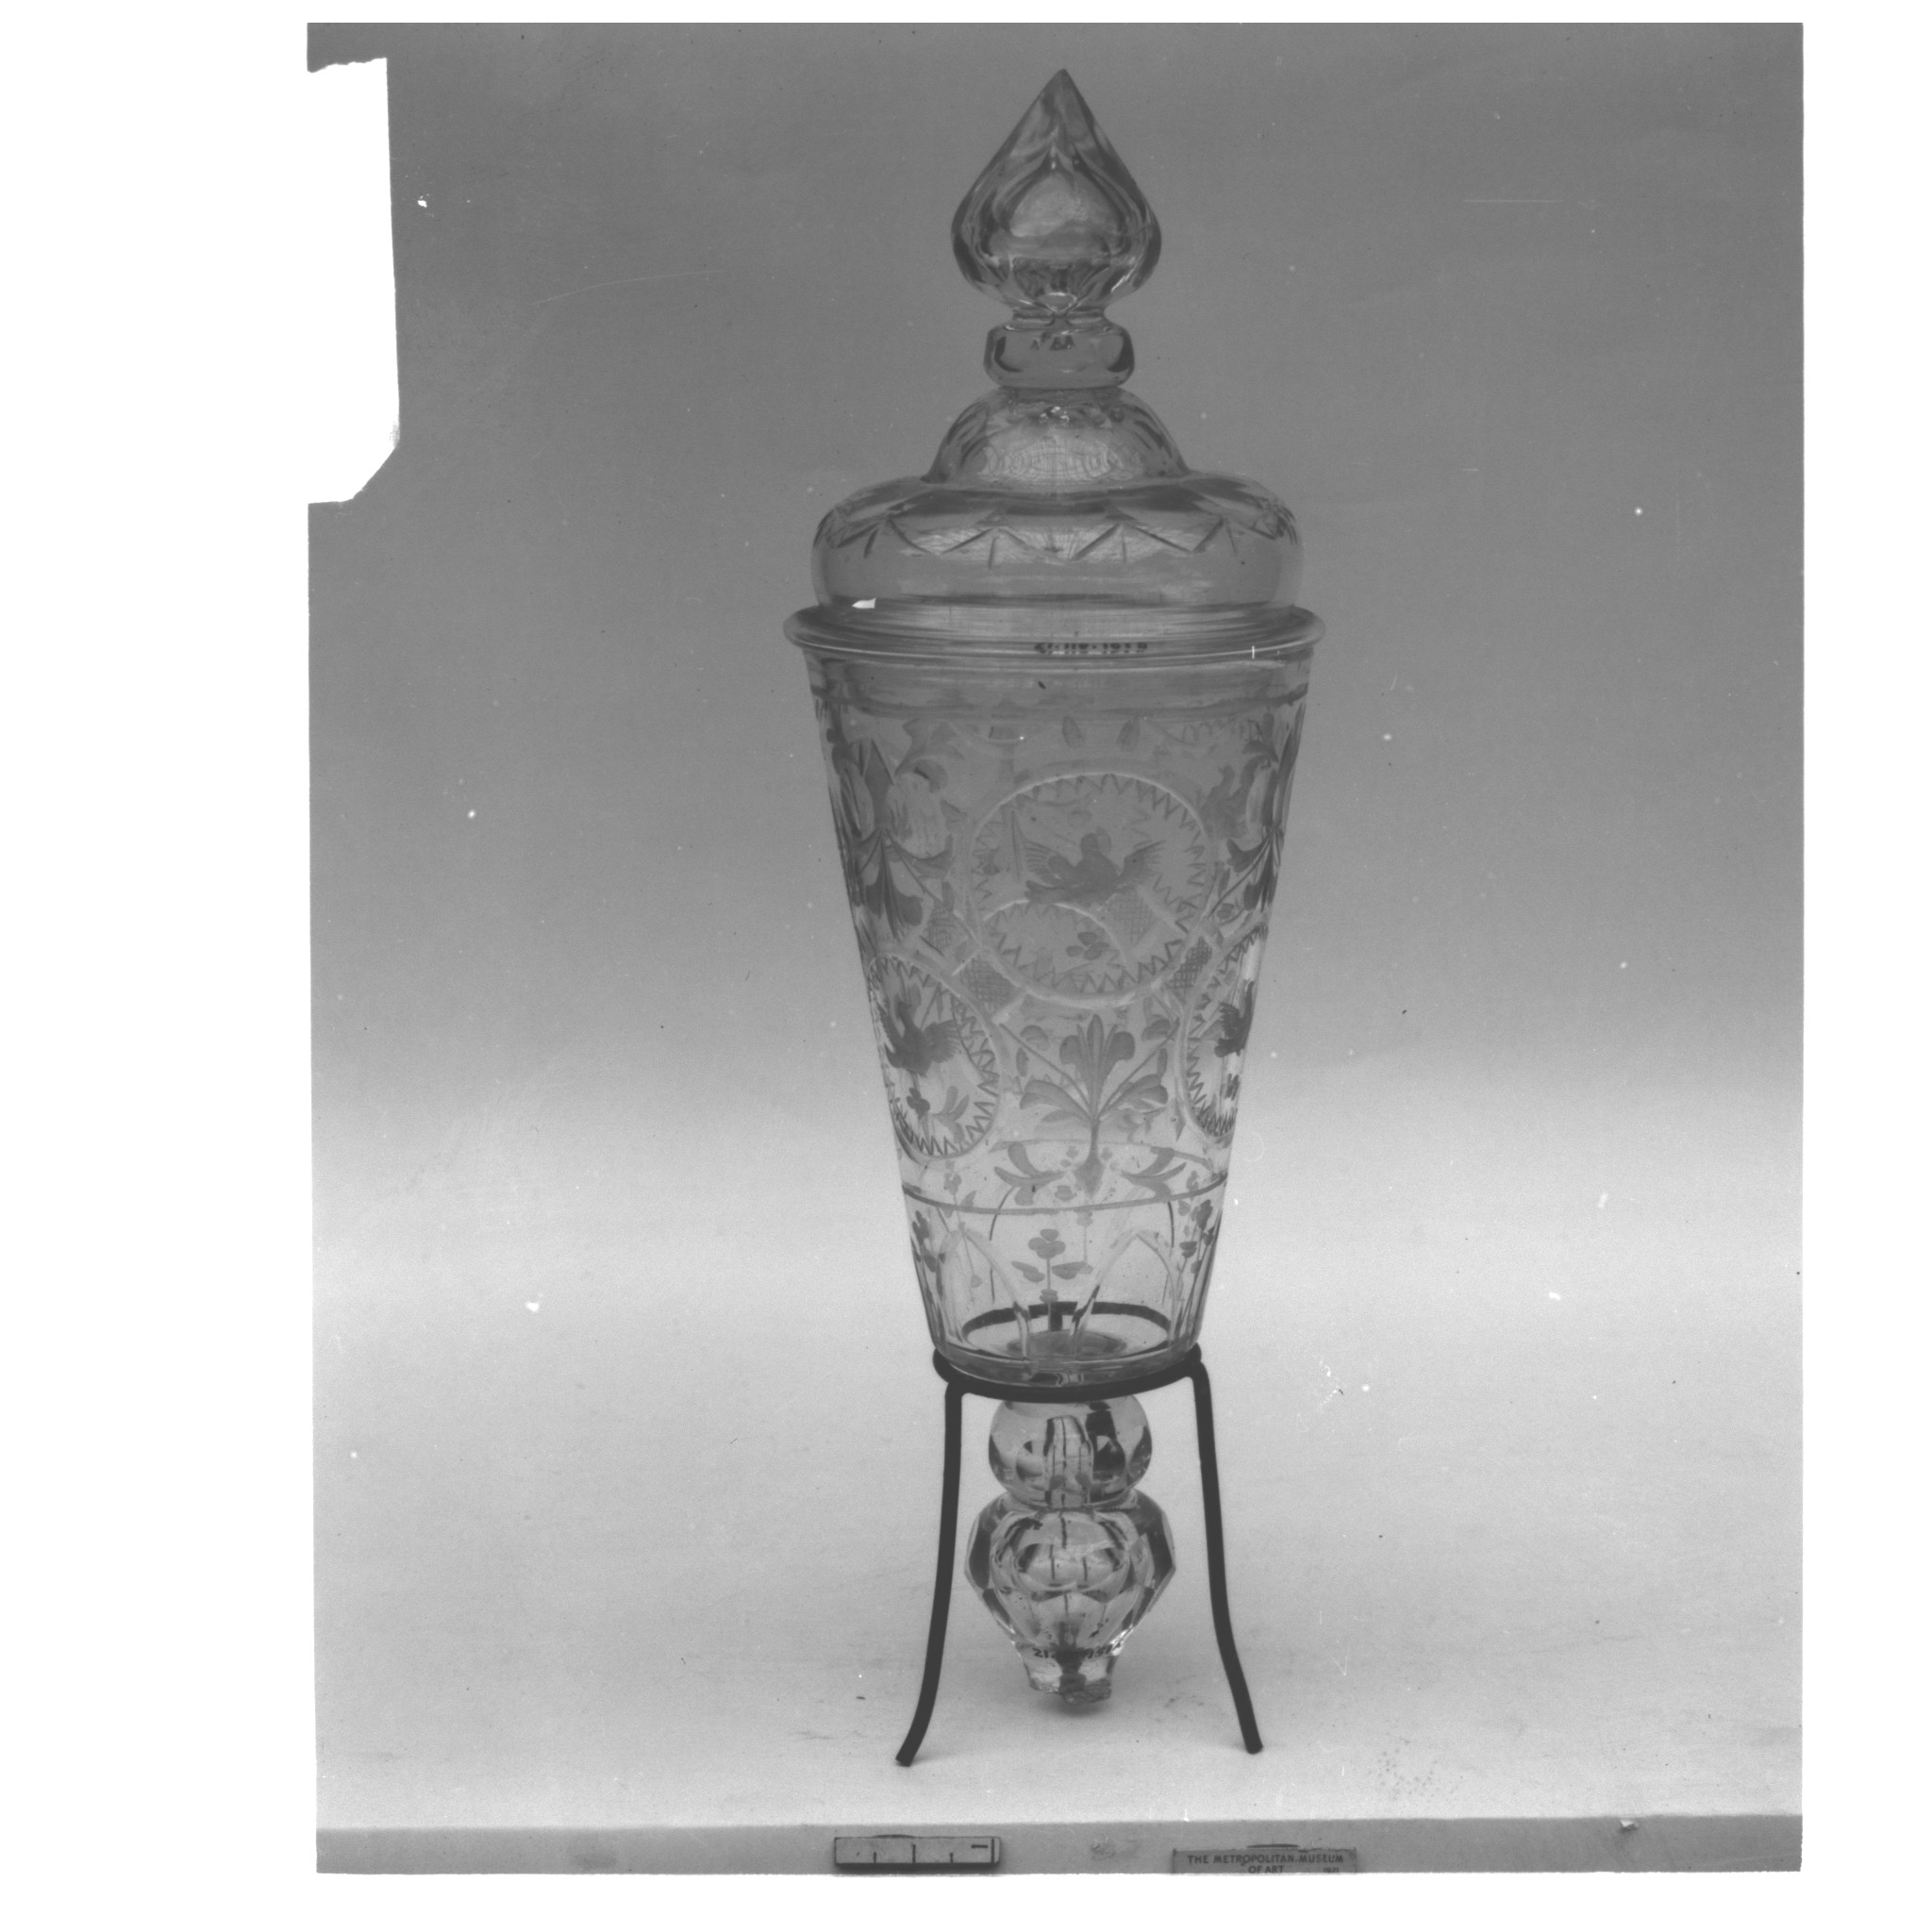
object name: wineglass with cover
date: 1667-1733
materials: glass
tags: birds,flowers